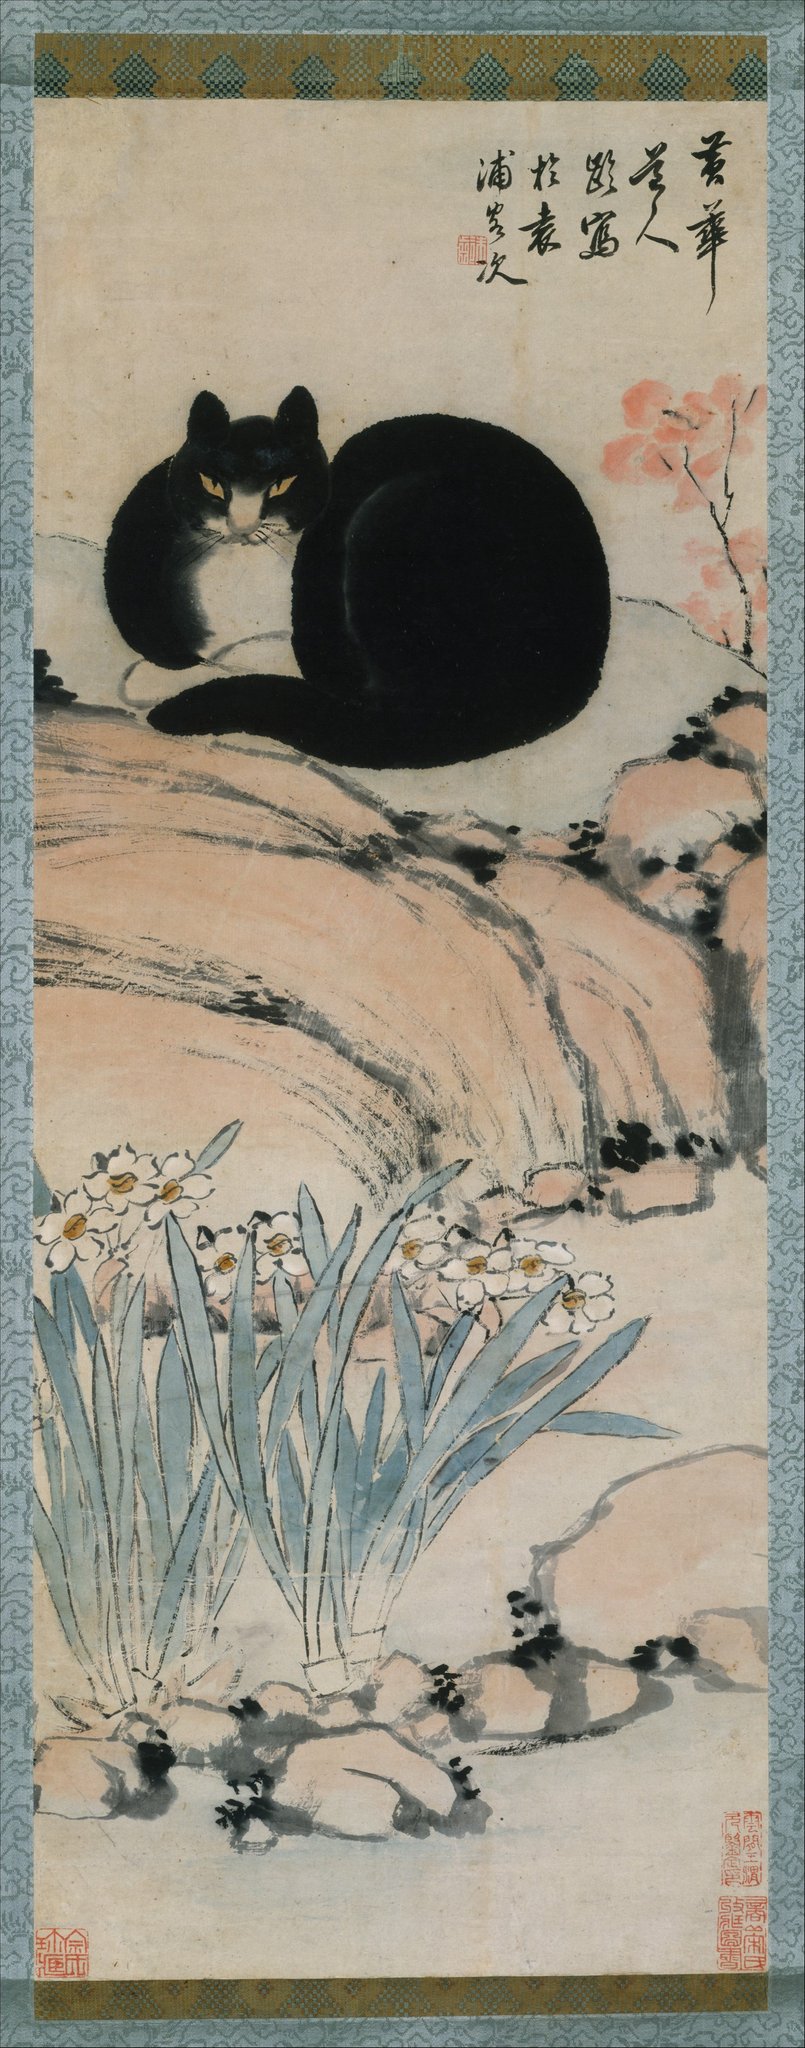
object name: hanging scroll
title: Black Cat and Narcissus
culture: chinese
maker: zhu ling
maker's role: artist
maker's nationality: chinese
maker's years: 1820-1850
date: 1801-1900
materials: ink, paper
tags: cats,narcissus